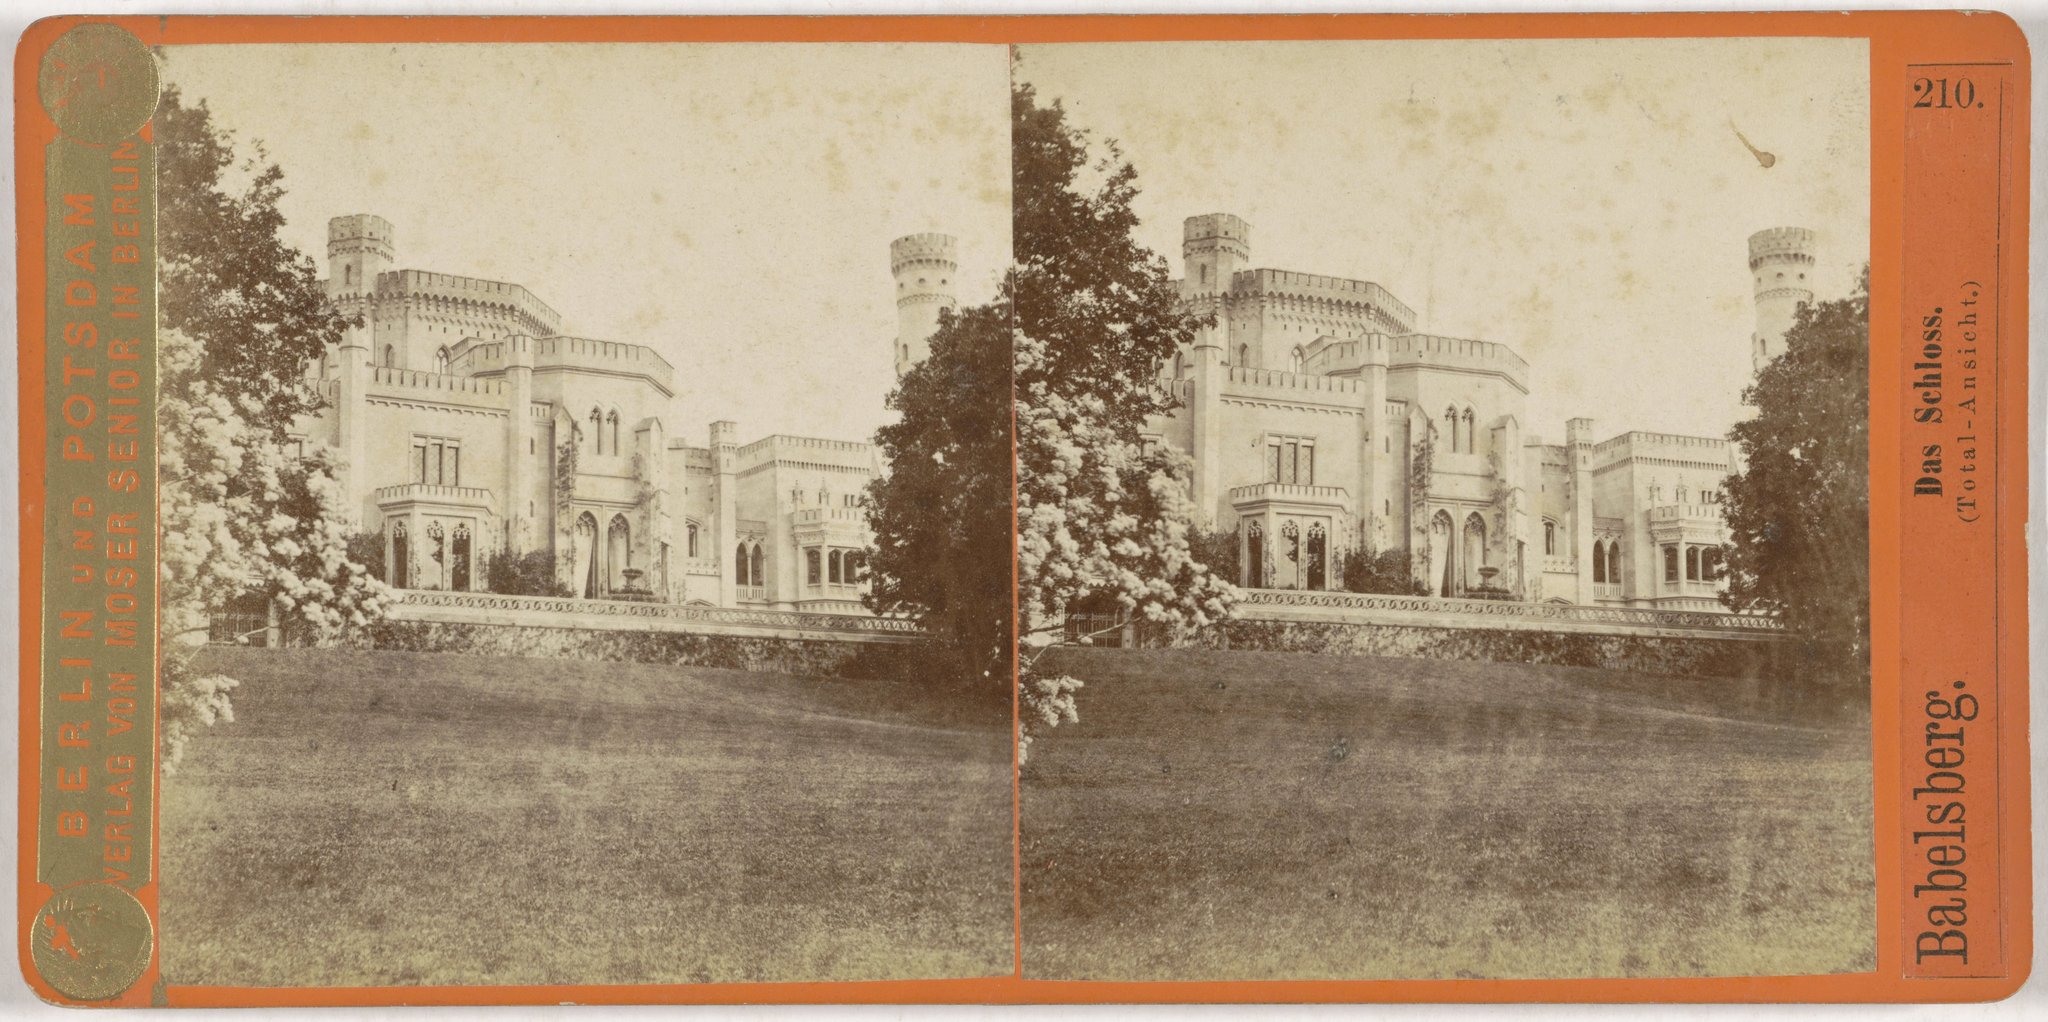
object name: stereograph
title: Slot Babelsberg in Potsdam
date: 1862-1882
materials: cardboard, paper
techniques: albumen print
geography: berlin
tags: castle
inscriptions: number: ‘210.’